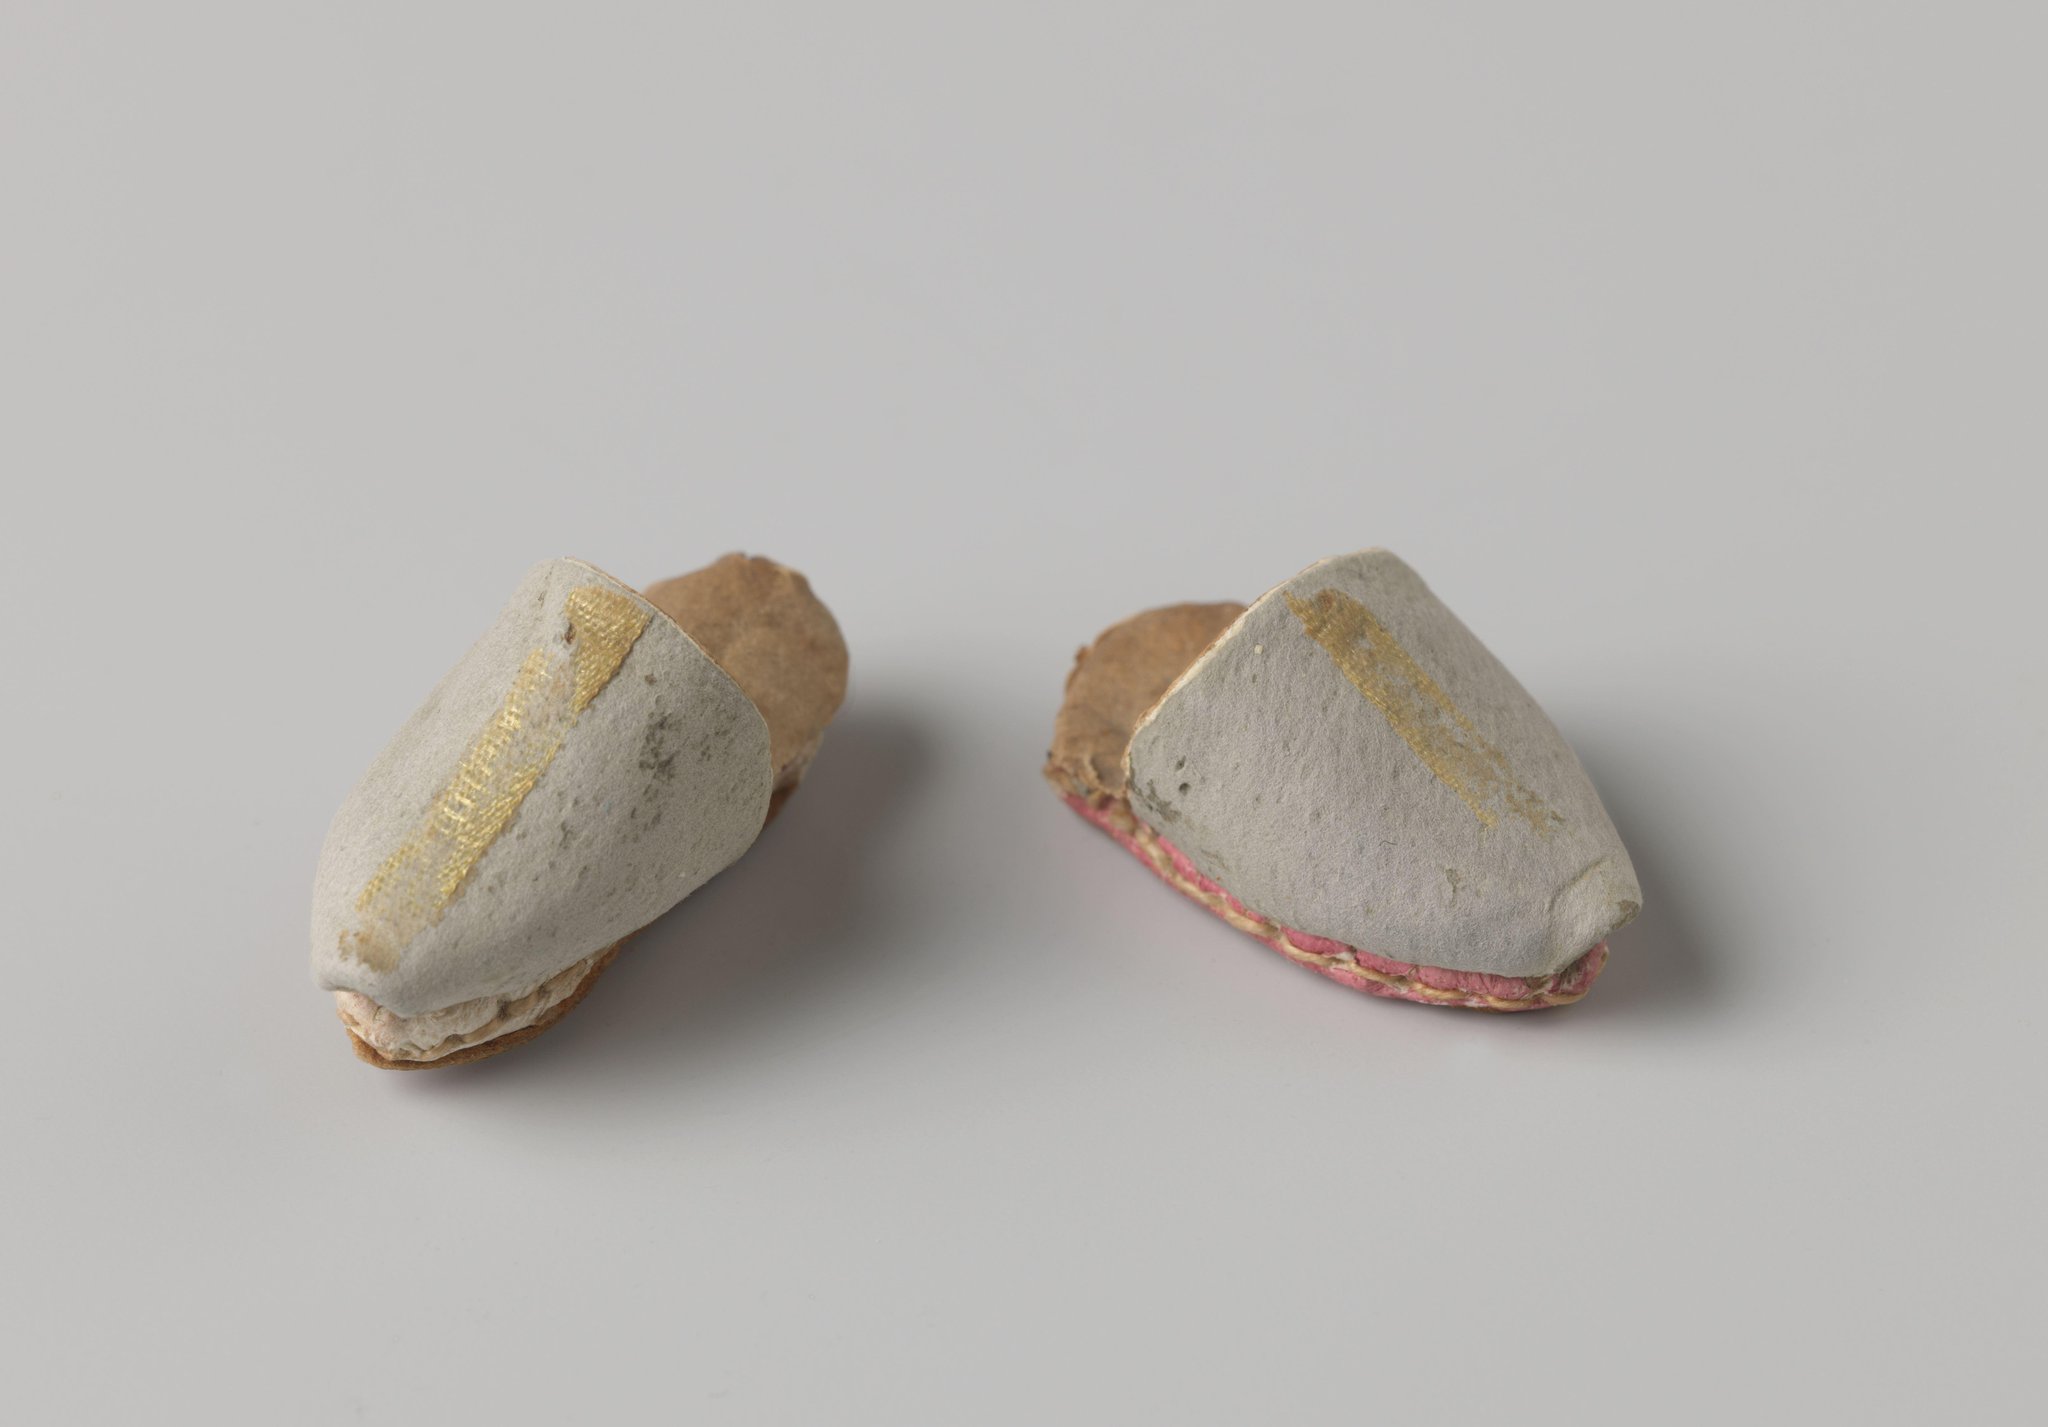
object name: miniature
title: Paar muilen, lichtblauw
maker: Anonymous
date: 1740-1760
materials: leather, paper, wool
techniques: stitching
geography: amsterdam